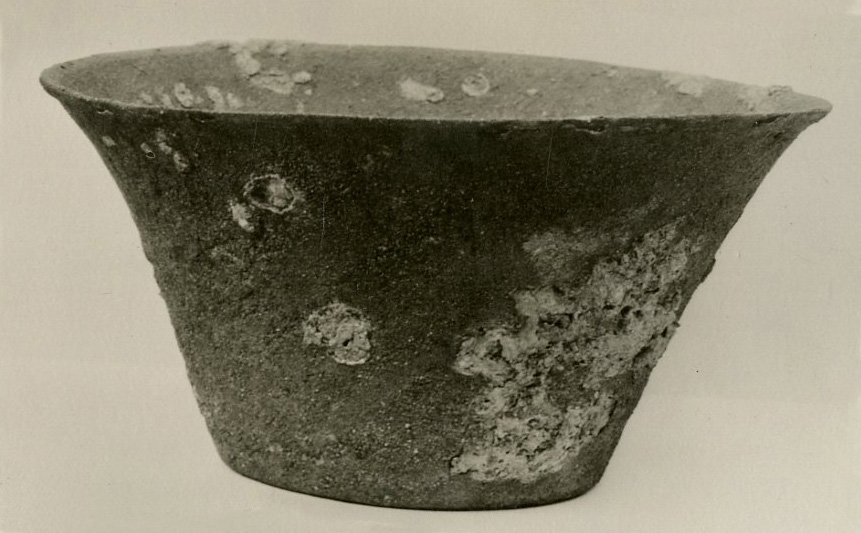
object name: basin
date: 2323-2150 BCE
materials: copper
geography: egypt